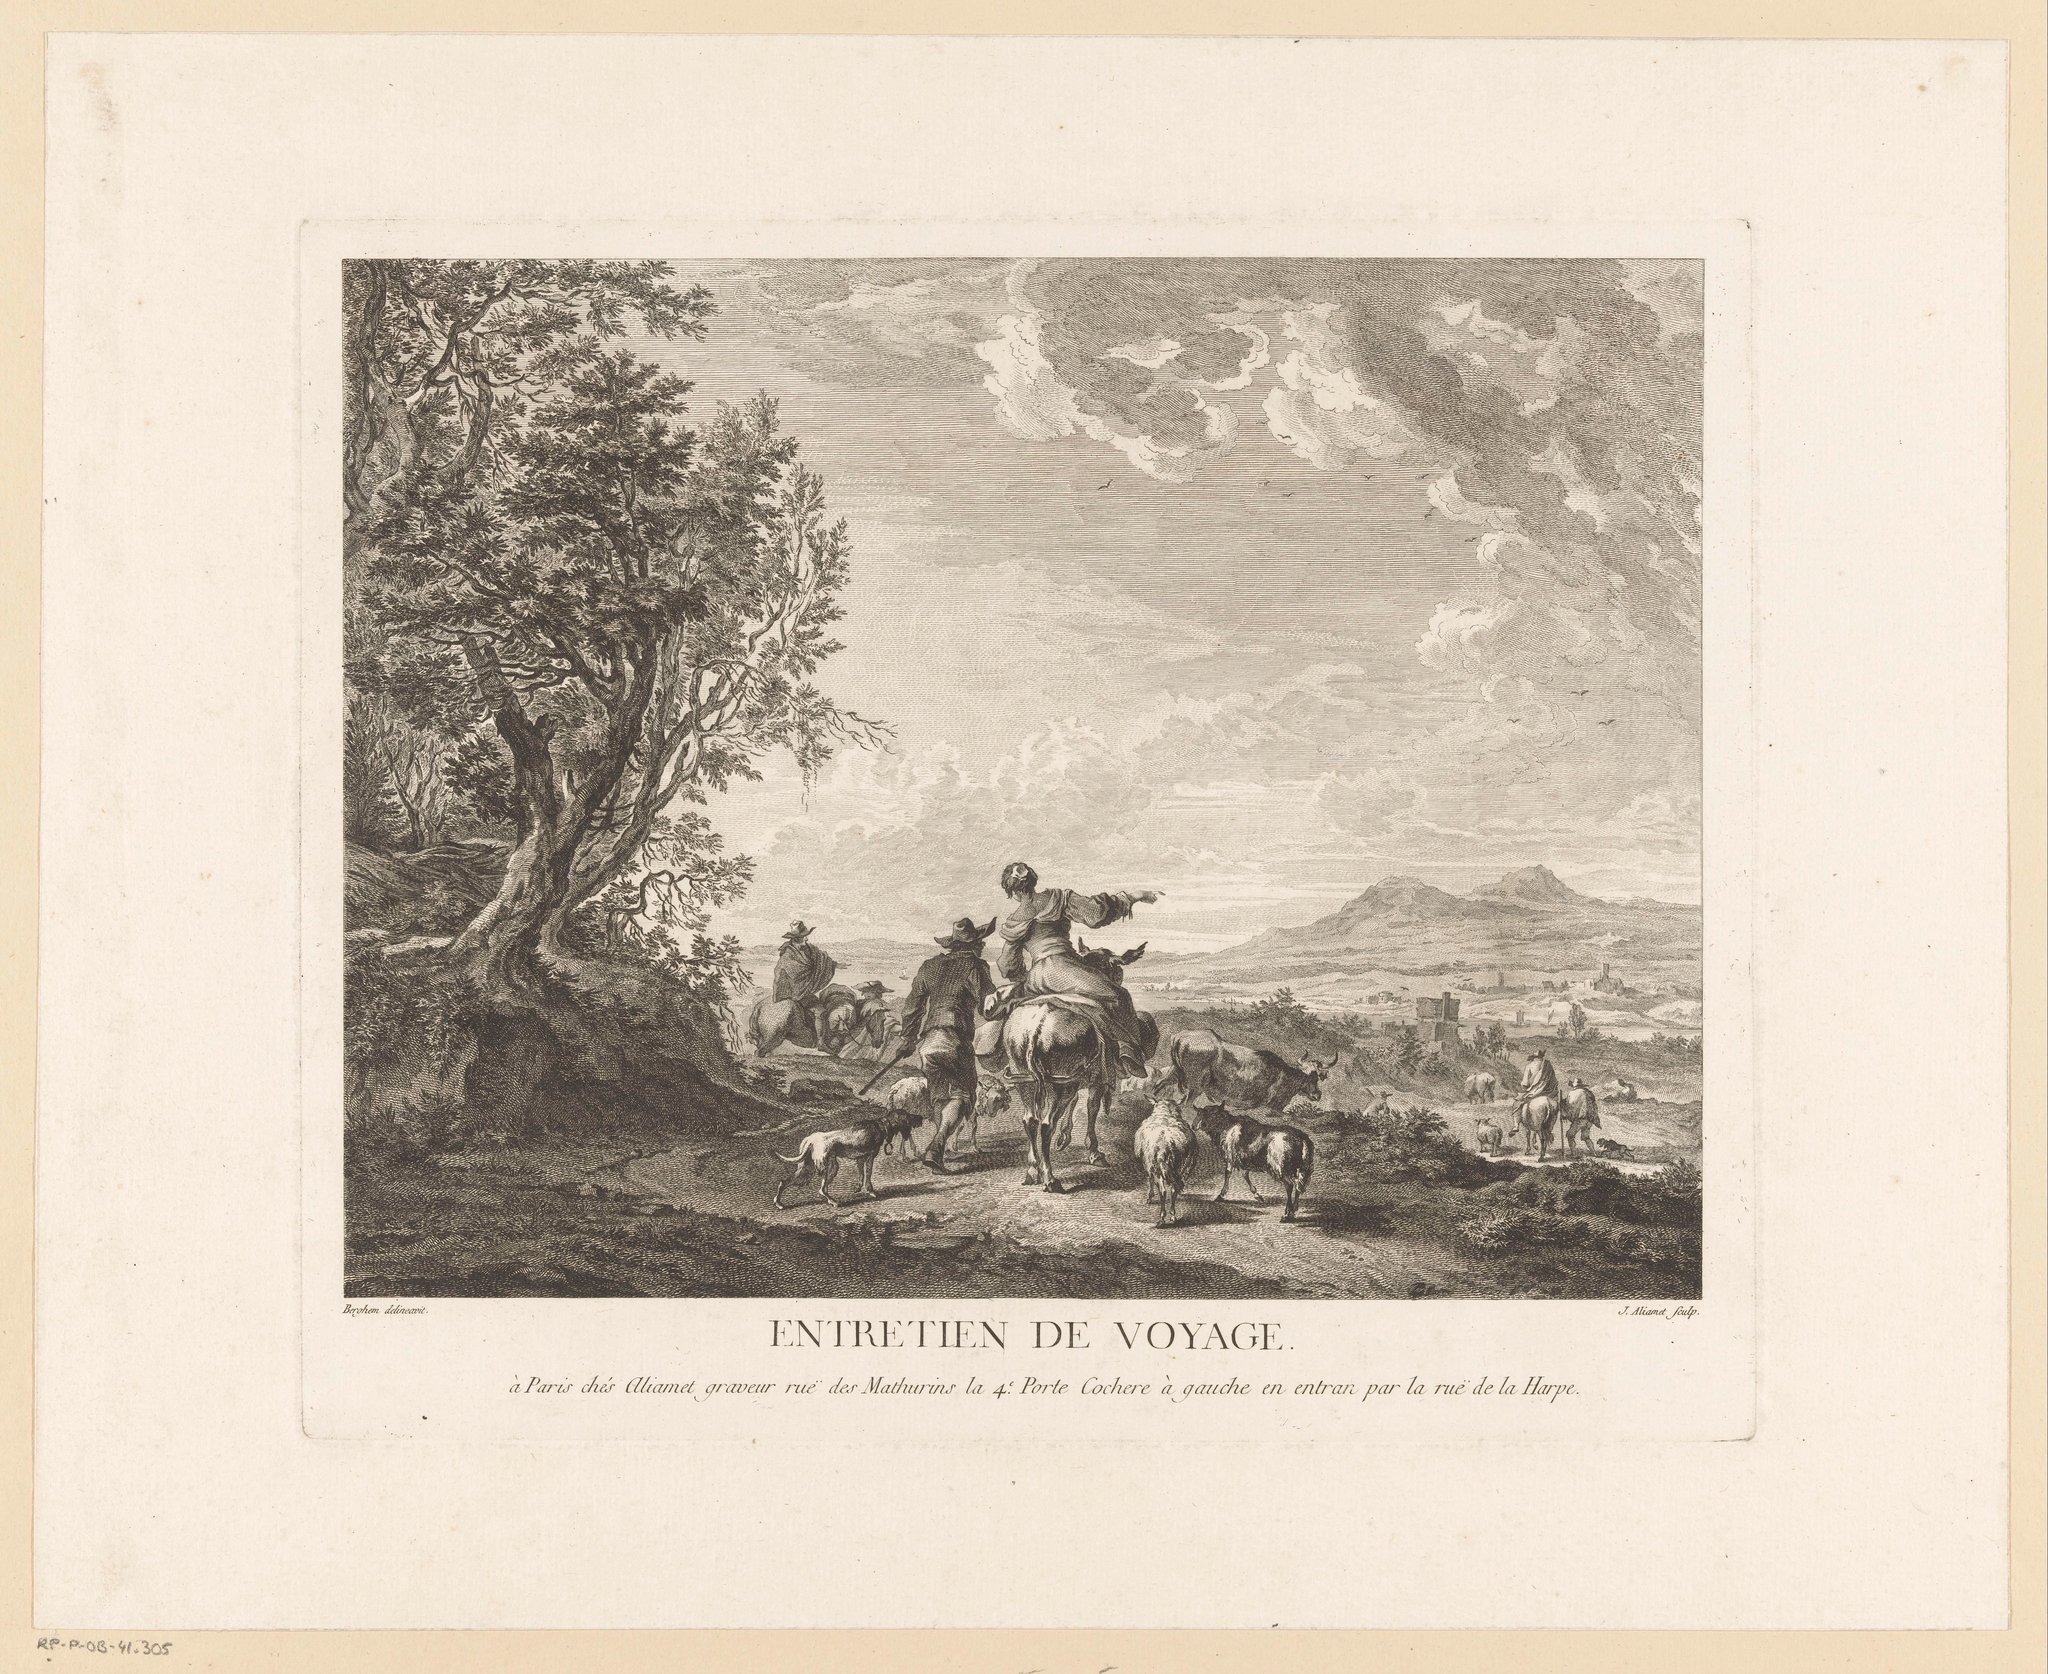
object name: print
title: Reizigers in een landschap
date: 1750-1788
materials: paper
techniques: engraving, etching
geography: netherlands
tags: landscapes, herd, flock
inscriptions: collector's mark: Lugt 240